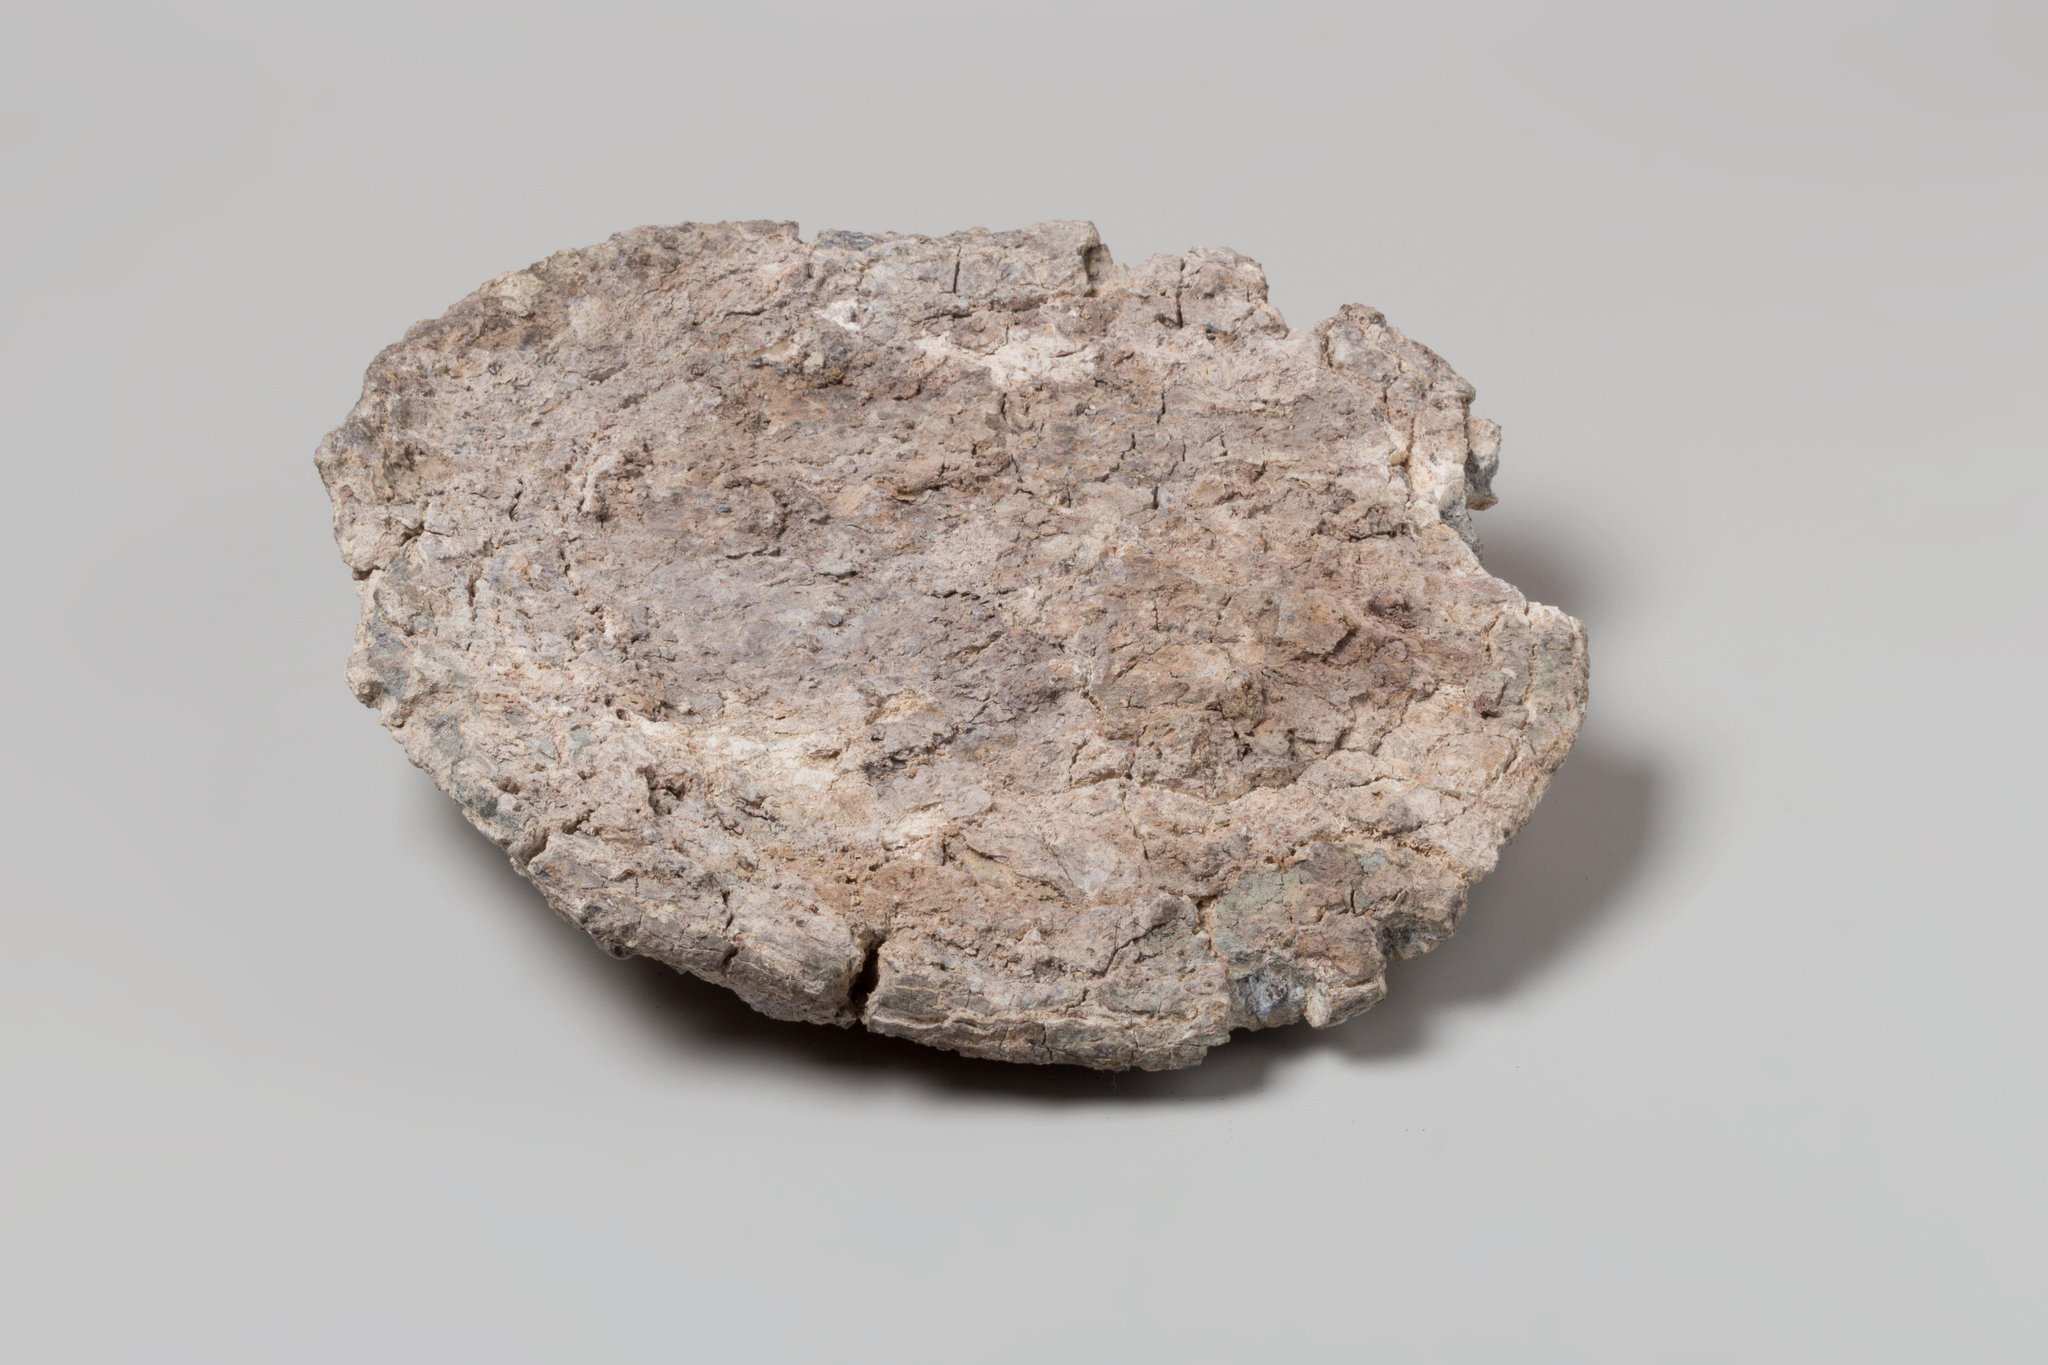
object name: concretionary stone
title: Concretie uit V.O.C.-schip de 'Witte Leeuw'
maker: Anonymous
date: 1613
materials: lead, pigment, tin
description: Bijna cirkelvormig stuk concretie met loden of tinnen kern. Mogelijk een stapel borden.